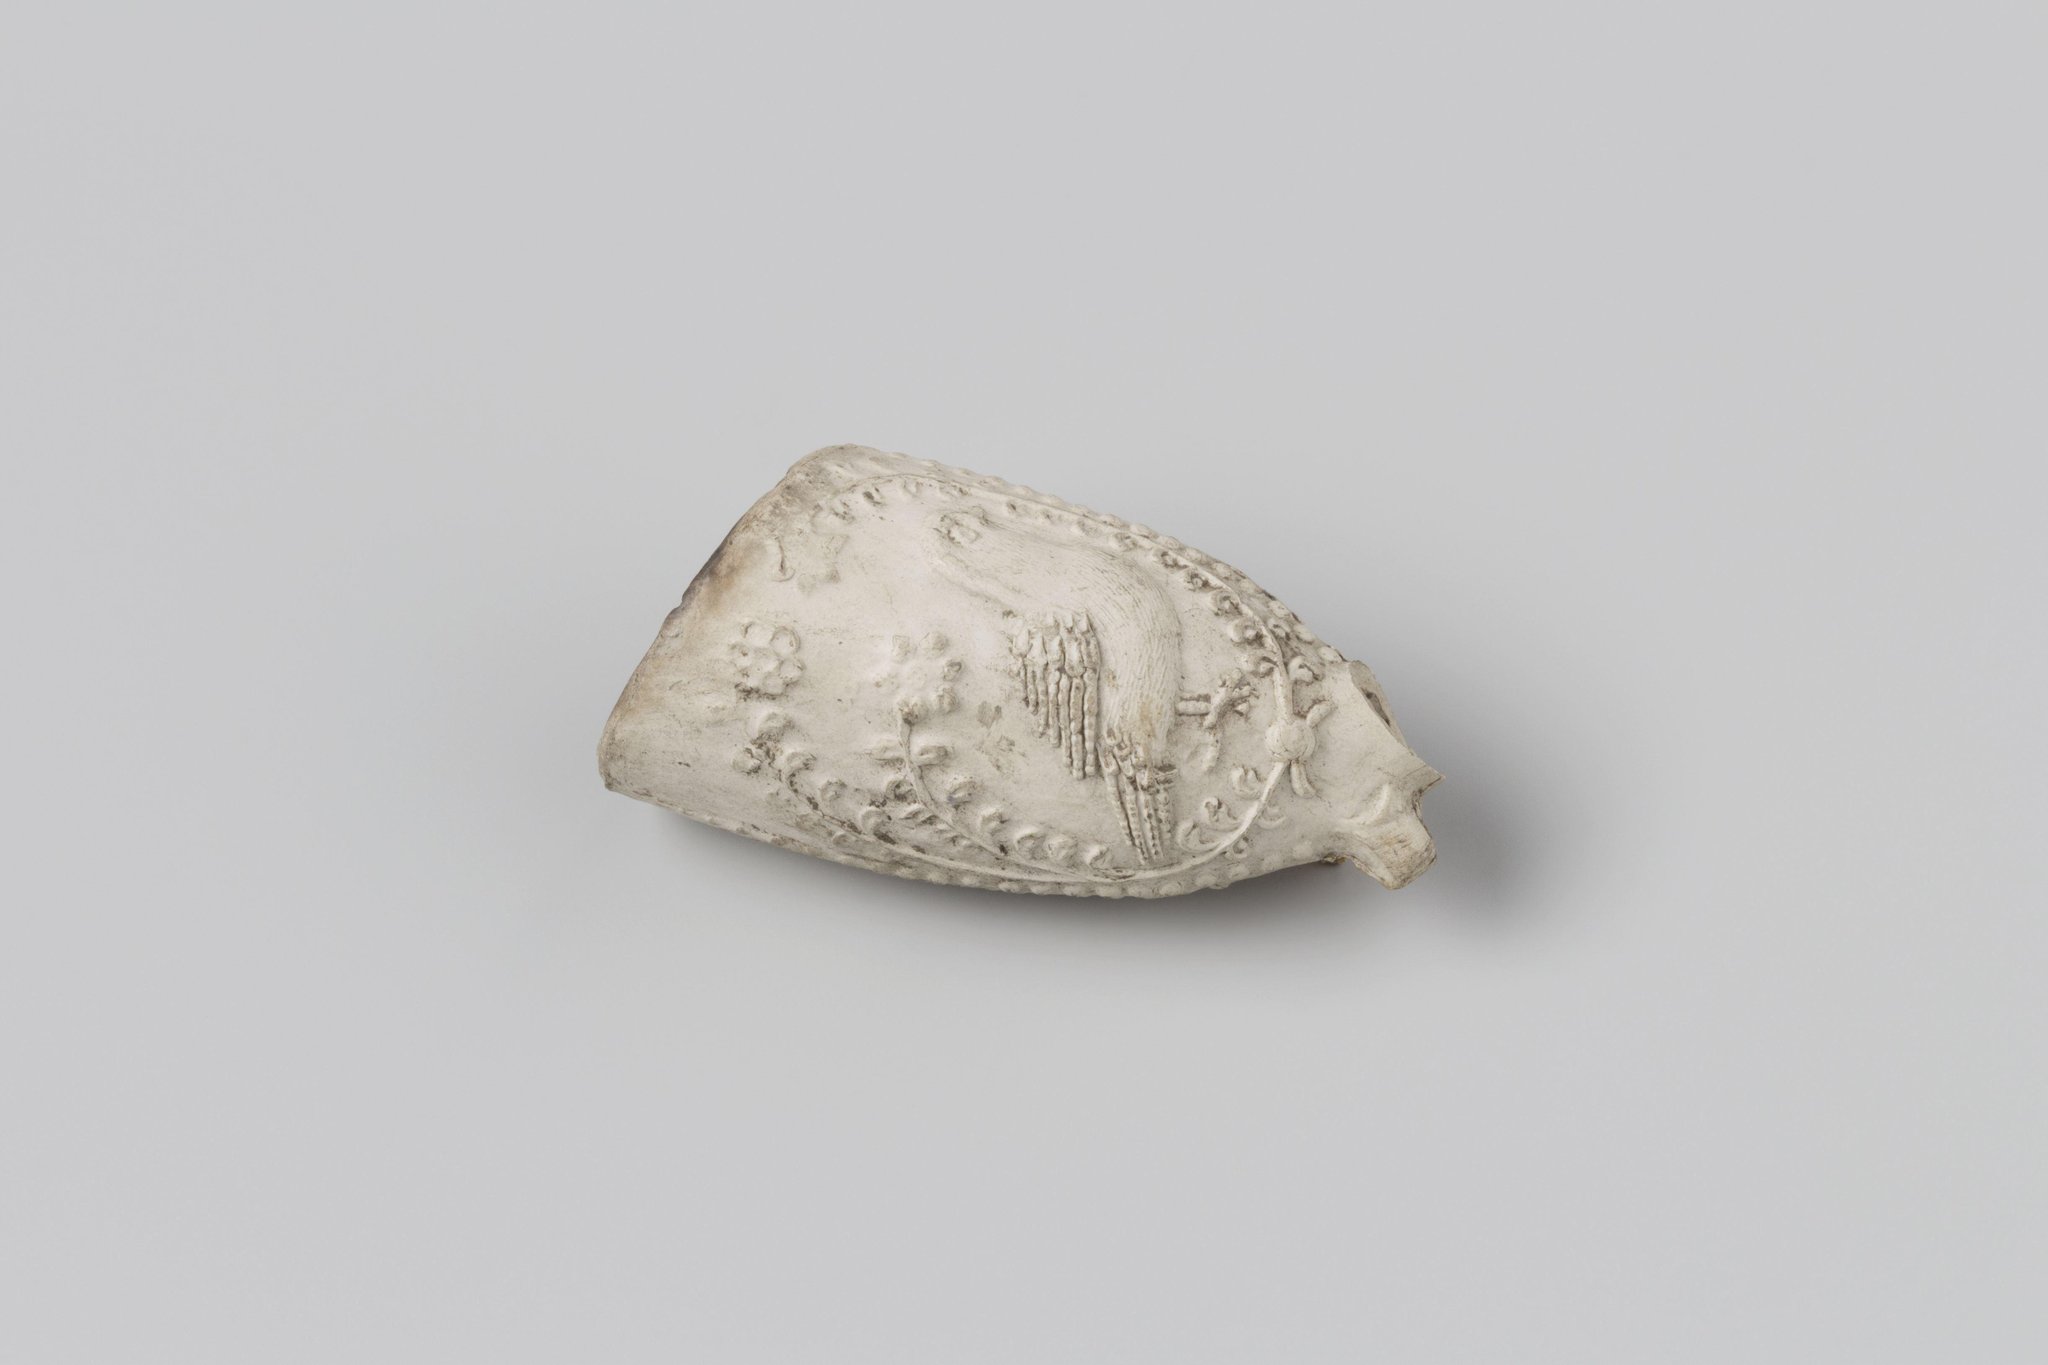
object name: fragment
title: Fragment pijpenkop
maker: Anonymous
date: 1710-1740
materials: clay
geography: netherlands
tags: other birds: dove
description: Fragment pijpenkop met een duif en een doffer, omsloten door bloemranken. Van de opgravingen op de Hofstede Arentsburg 1827-1831 onder toezicht van Professor Reuvens.